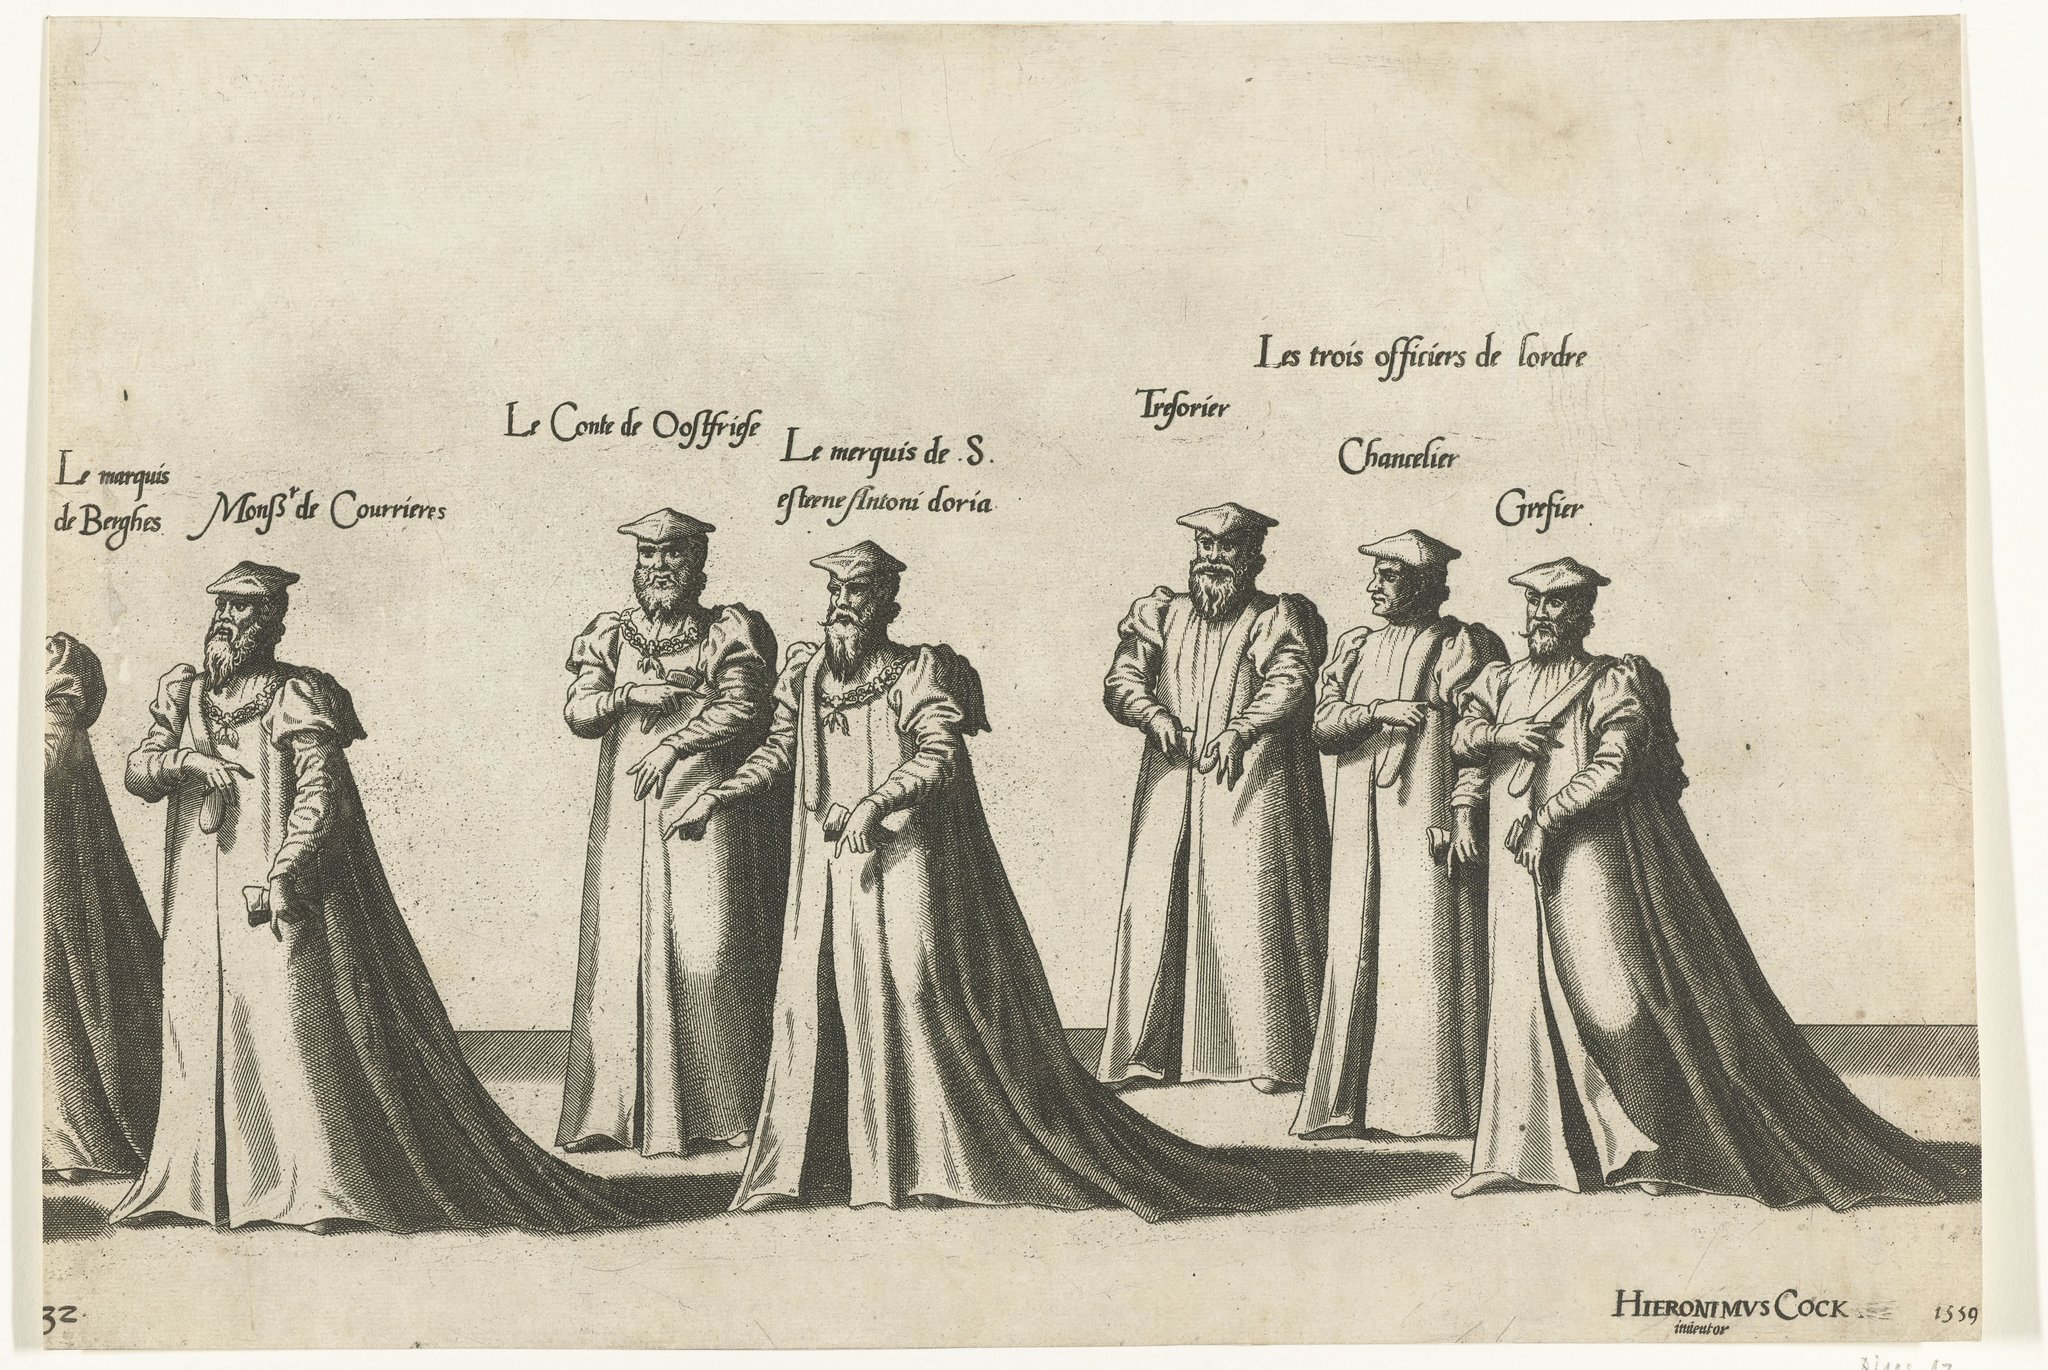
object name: print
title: La magnifique, et sumptueuse Pompe Funebre, faite aus Obseques & Funerailles du tres-grand & tres-victorieus Empereur Charles Cinquième, Celebrées en la Vile de Bruxelles le XXIX. Iour du Mois de Decembre M.D.LVIII. par Philippes Roy Catholique d'Espaignes son Fils.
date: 1559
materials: paper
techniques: engraving, etching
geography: southern netherlands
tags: ghent, charles v (holy roman emperor and king of spain), cortege, funeral procession, knighthood order of the golden fleece, brussels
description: Drie vliesridders en drie officieren van de orde die deelnemen aan de optocht. Onderdeel van de prentreeks van de Begrafenisoptocht van keizer Karel V op 29 december 1558 te Brussel.